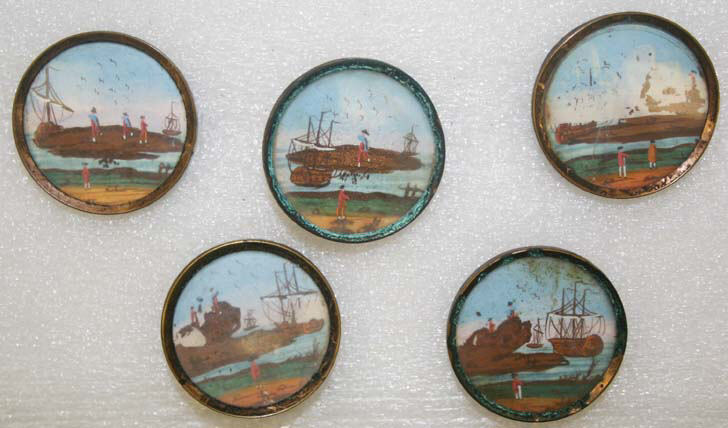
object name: button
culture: french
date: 1775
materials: glass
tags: ships